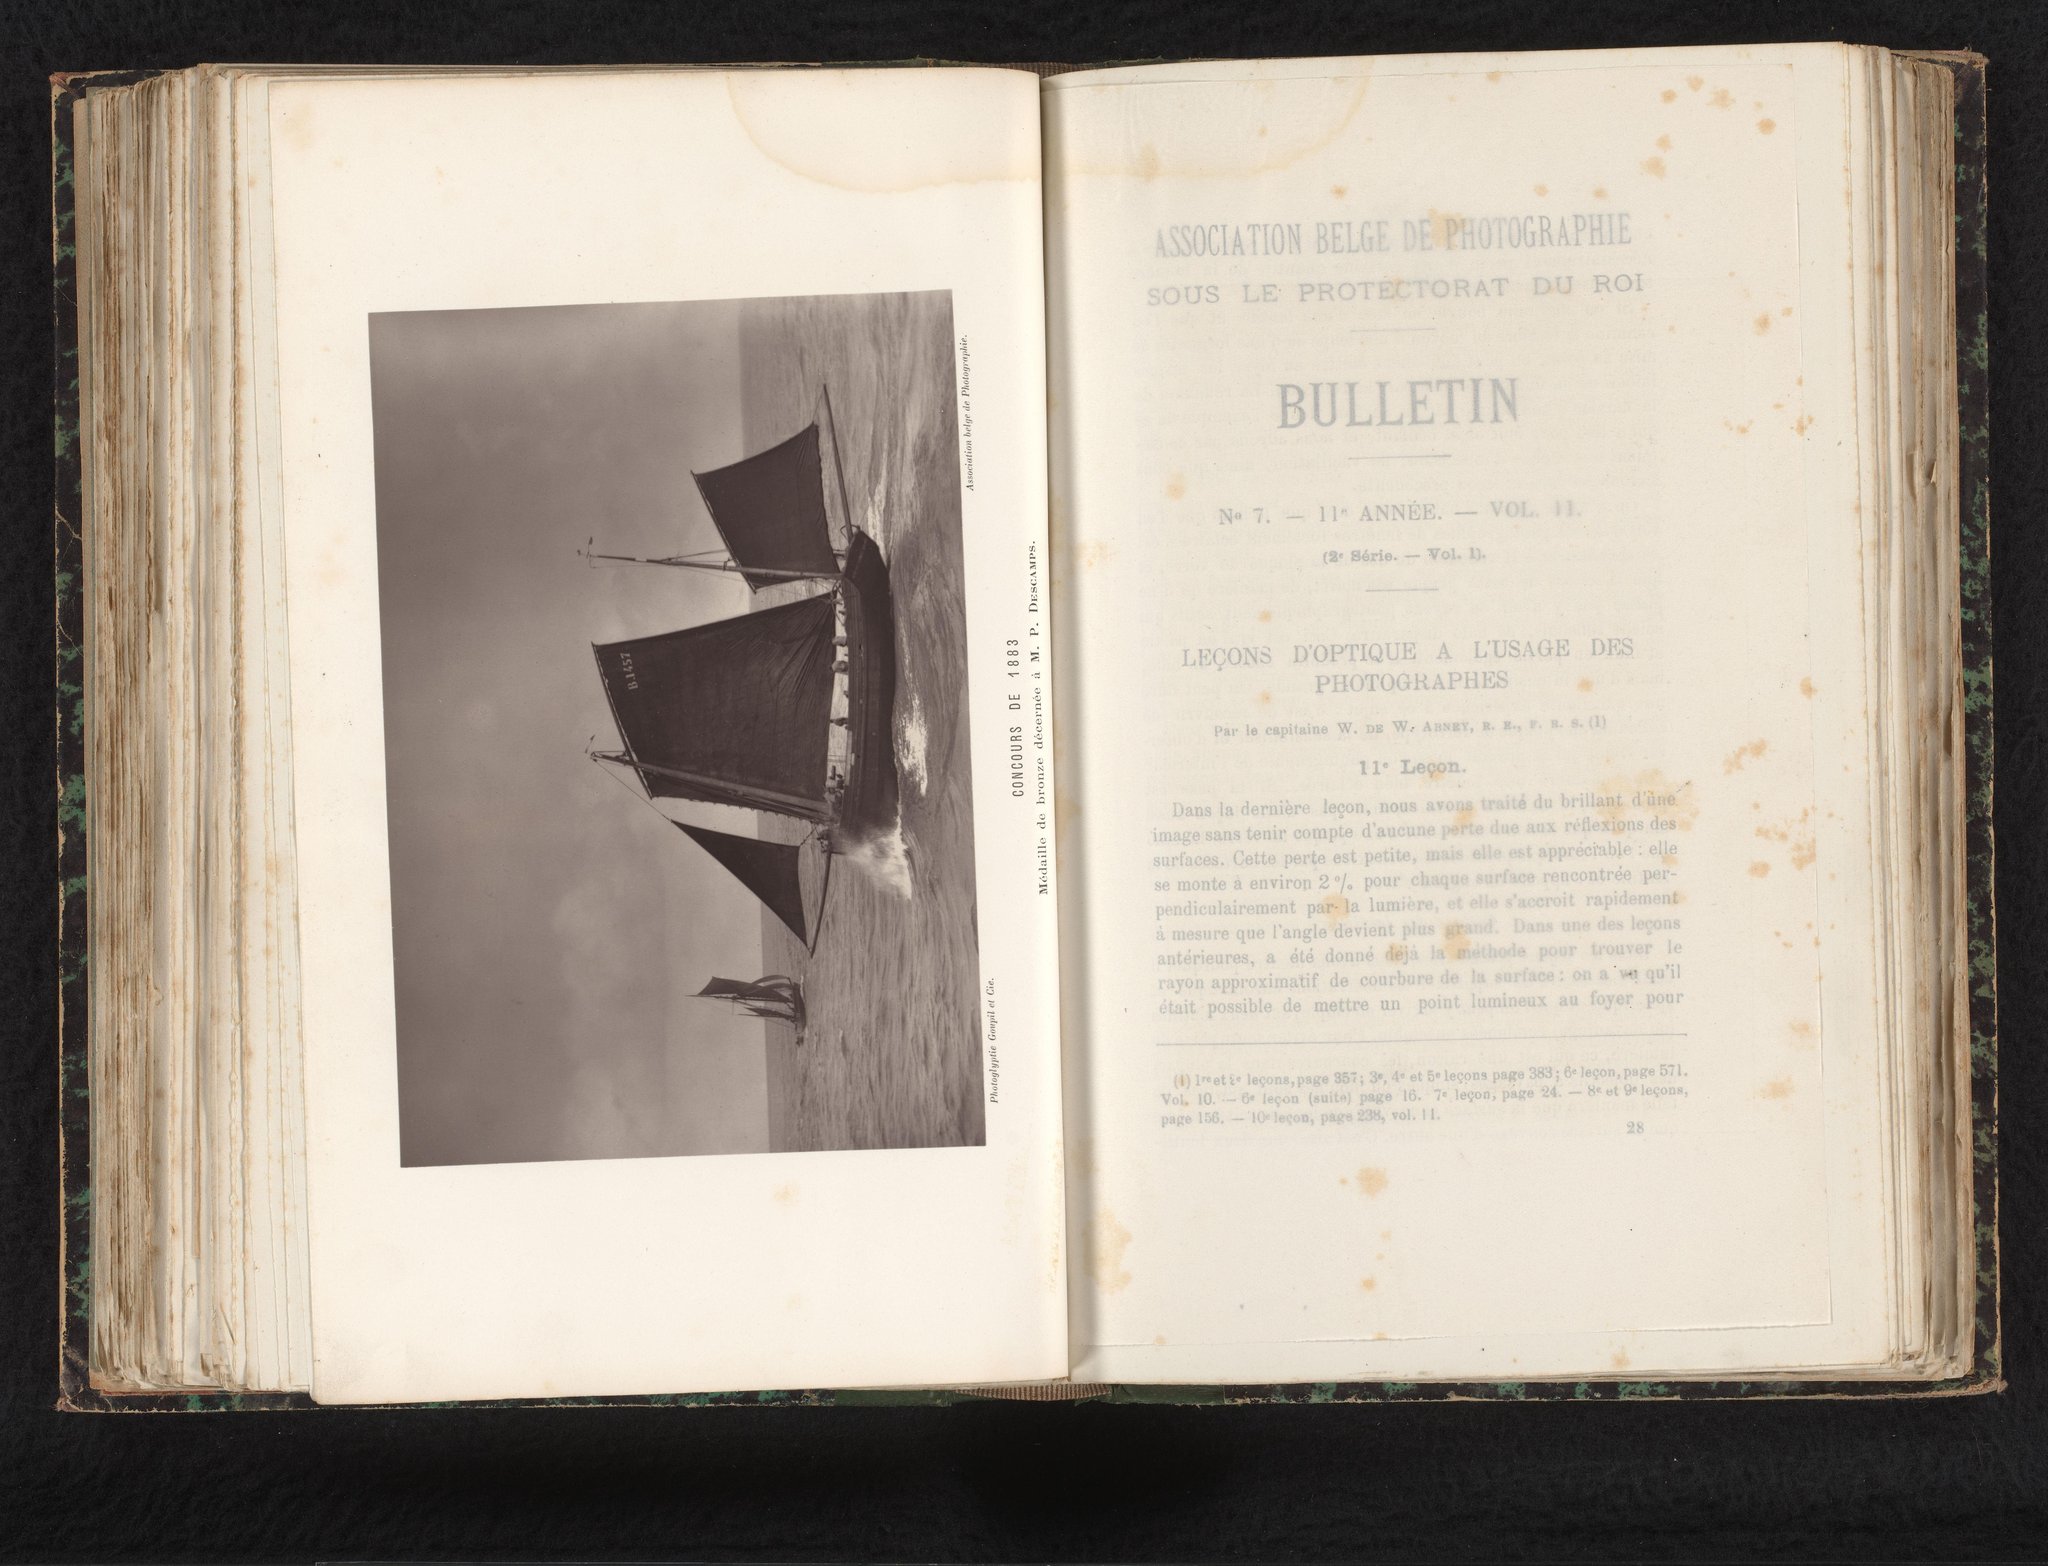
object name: page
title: Zeegezicht met zeilschip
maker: palmer descamps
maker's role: goldsmith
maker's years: 1840-1884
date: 1878-1883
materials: paper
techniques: woodburytype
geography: paris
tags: sailing-ship, sailing-boat, sea (seascape)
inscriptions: inscription: ‘Concours de 1883/ Médaille de bronze décernée à M. P. Descamps.’